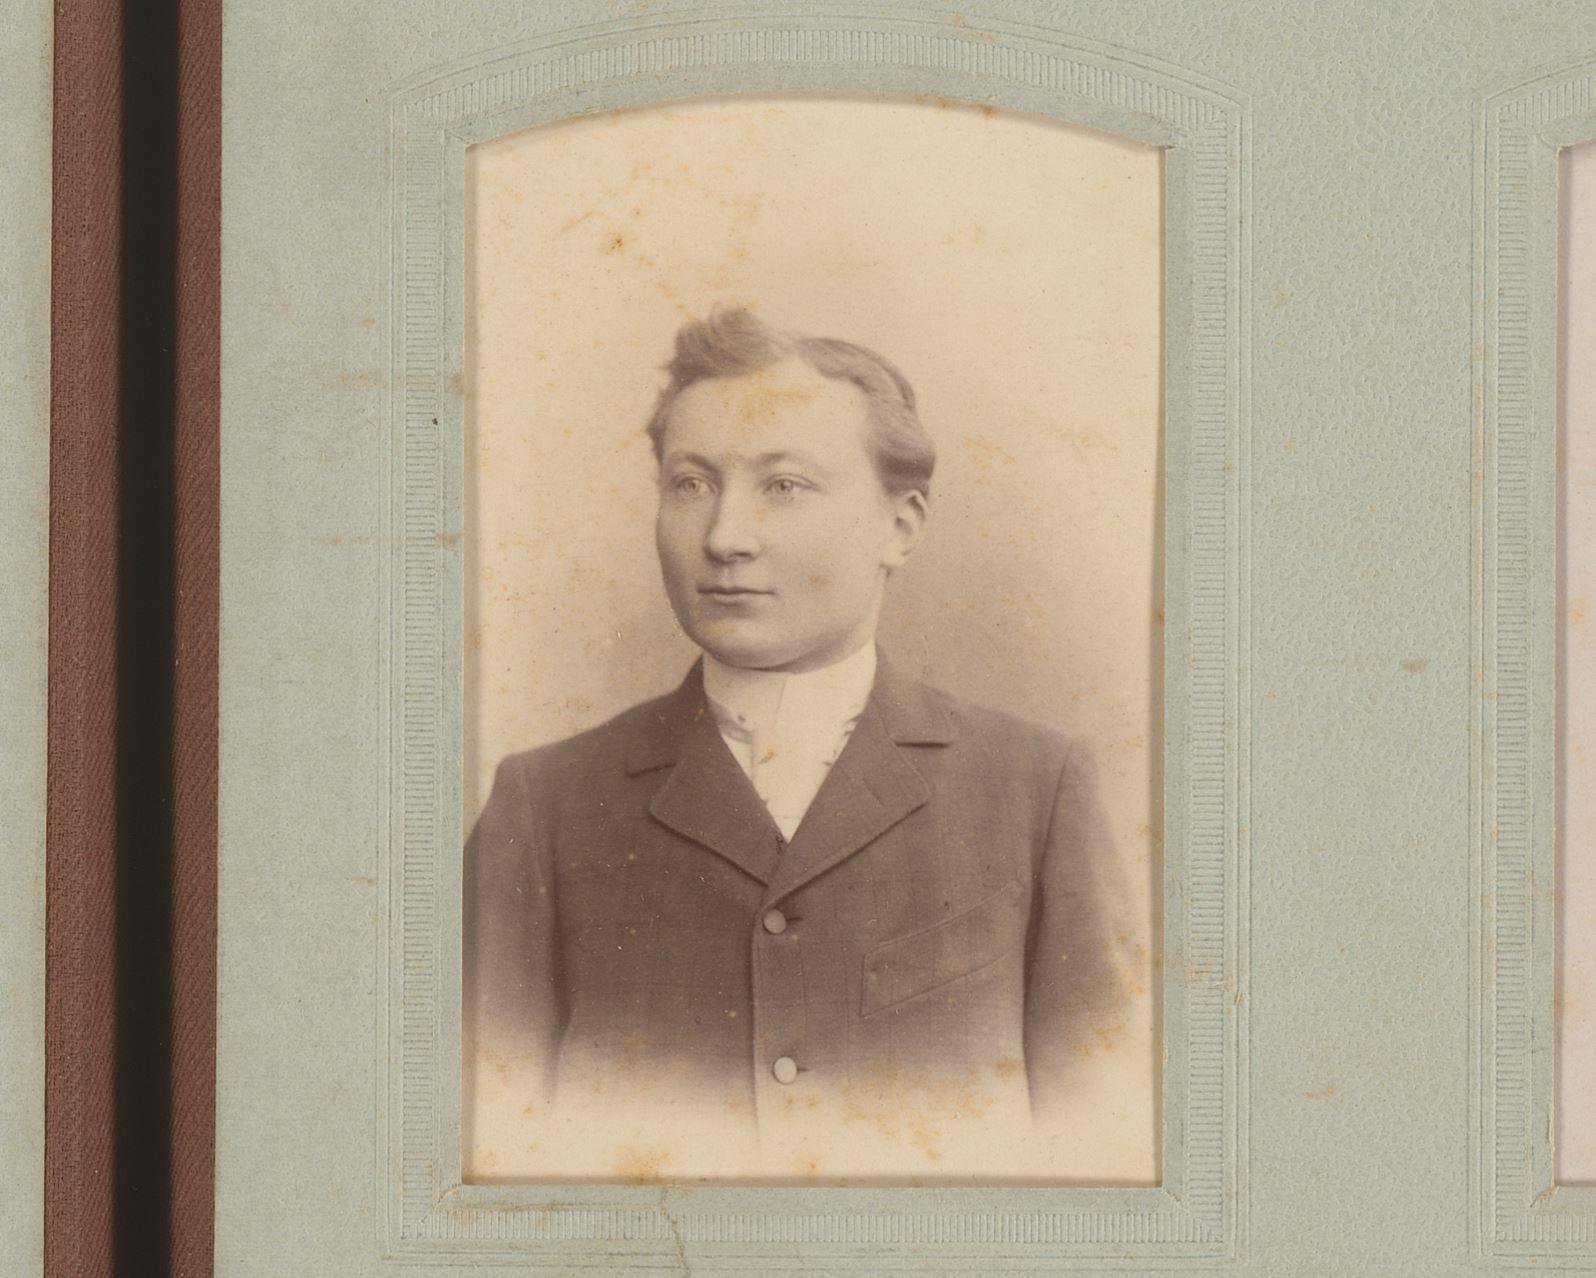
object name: album leaf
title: Portret van een onbekende jongeman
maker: max steffens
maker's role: fotograaf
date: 1866-1894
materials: cardboard, paper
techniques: albumen print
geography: berlin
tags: youth, adolescent, anonymous historical person portrayed, berlin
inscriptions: inscription: ‘Max Steffens/ Berlin, N./ Lothringerstr. 54.’, inscription: ‘Max Steffens/ Photograph. artist. Atelier./ Berlin, N./ Lothringer-Str. 54 (Rosenthaler Thor.)/ Die Platten werden aufbewahrt.’, inscription: ‘Opb.v.[...]/ 14 Juni.’